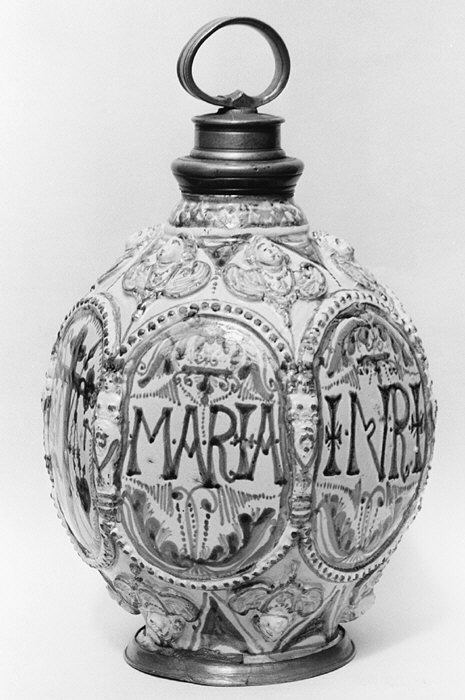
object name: bottle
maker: lorenz speckner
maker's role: maker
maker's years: 1598-1669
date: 1660-1670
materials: earthenware, pewter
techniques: glazing